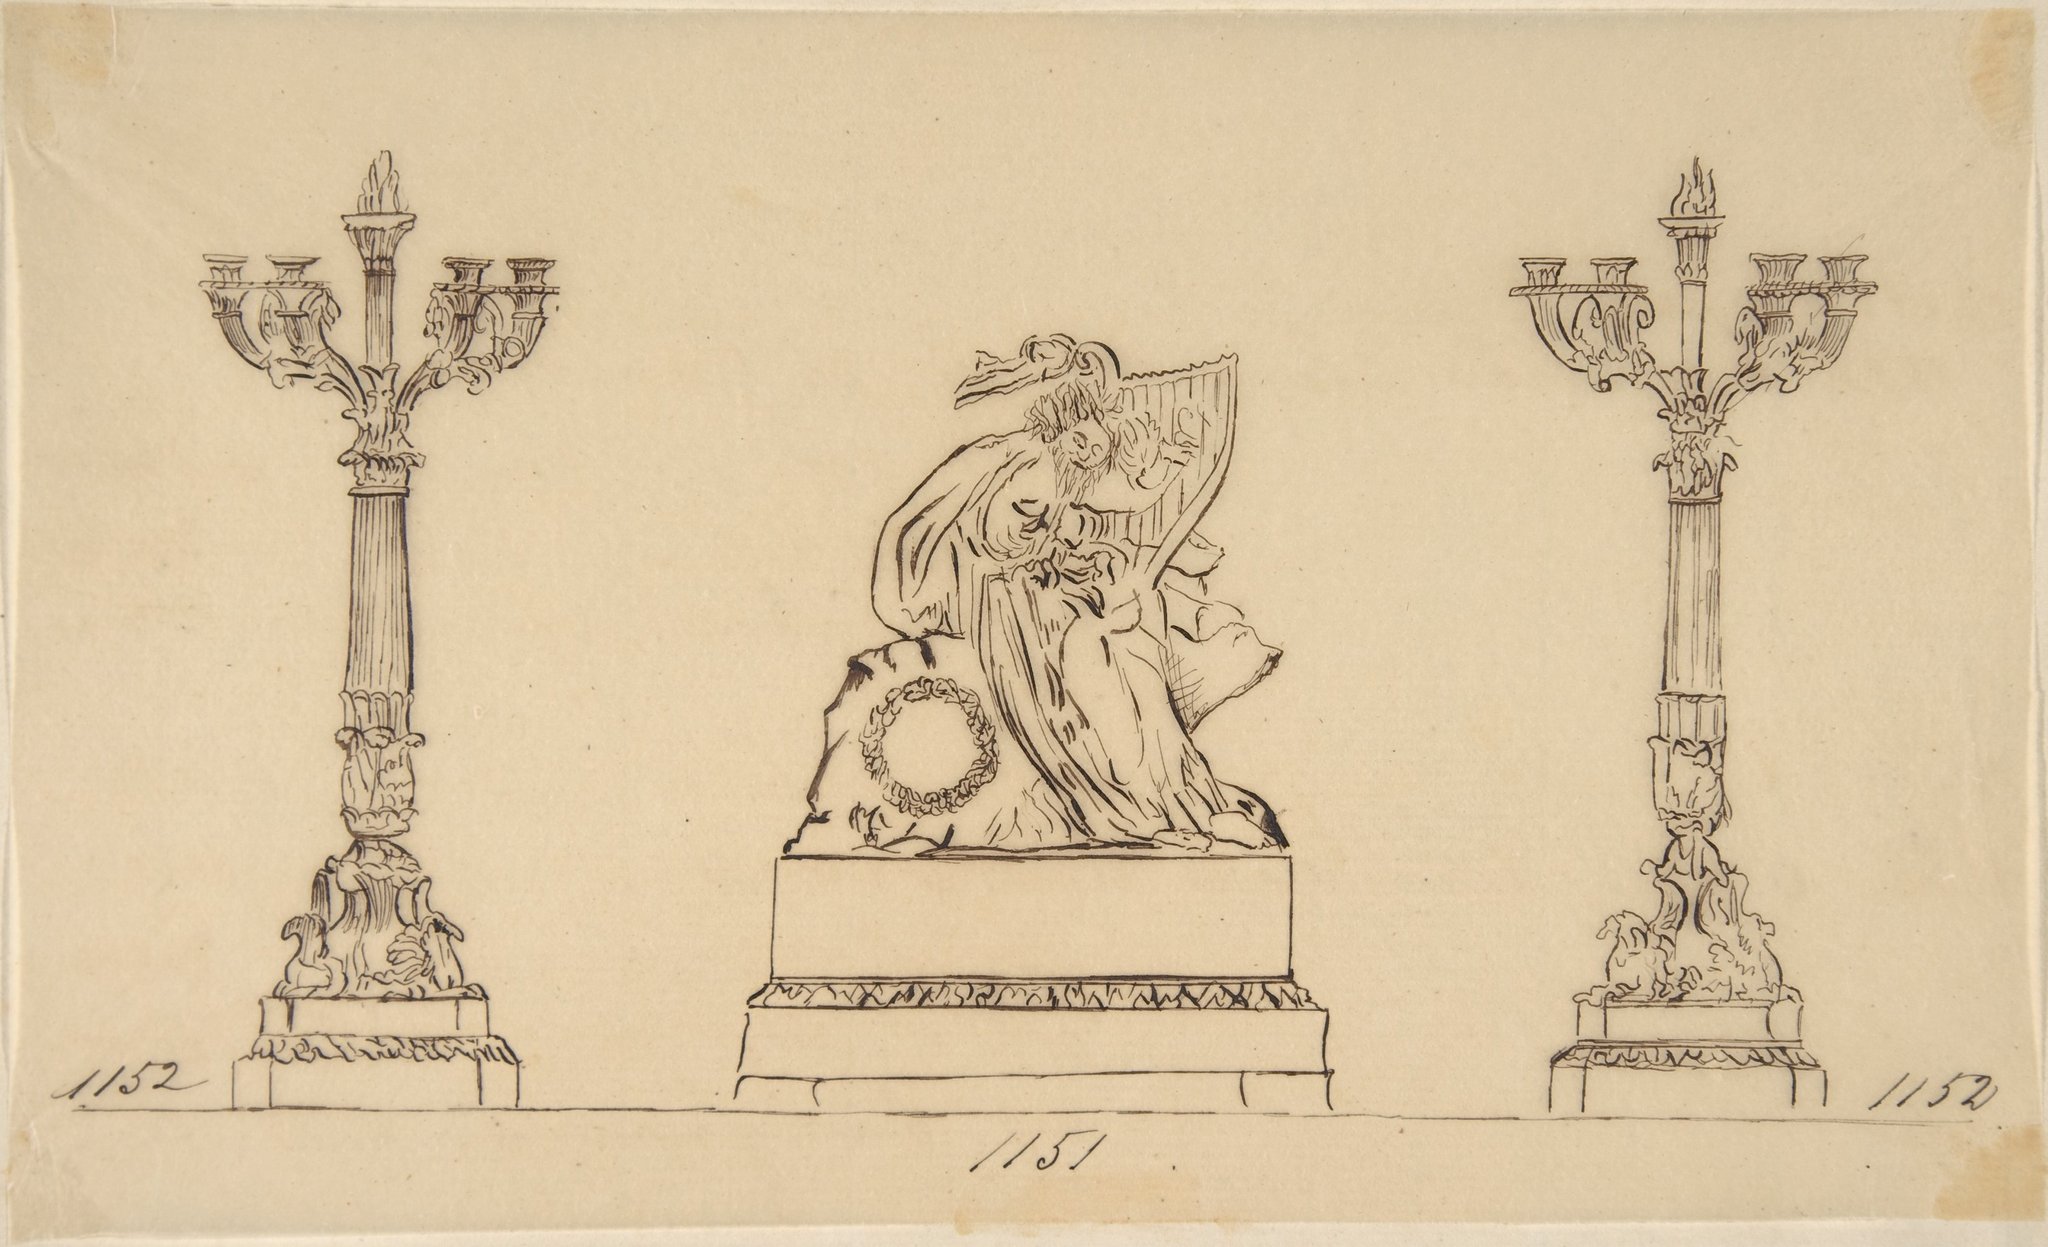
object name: drawing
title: Design for a Set of Candlesticks and a Clock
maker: anonymous, french, 19th century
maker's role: artist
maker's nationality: french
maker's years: 1800-1900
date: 1801-1900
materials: ink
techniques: pen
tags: clocks,candlesticks